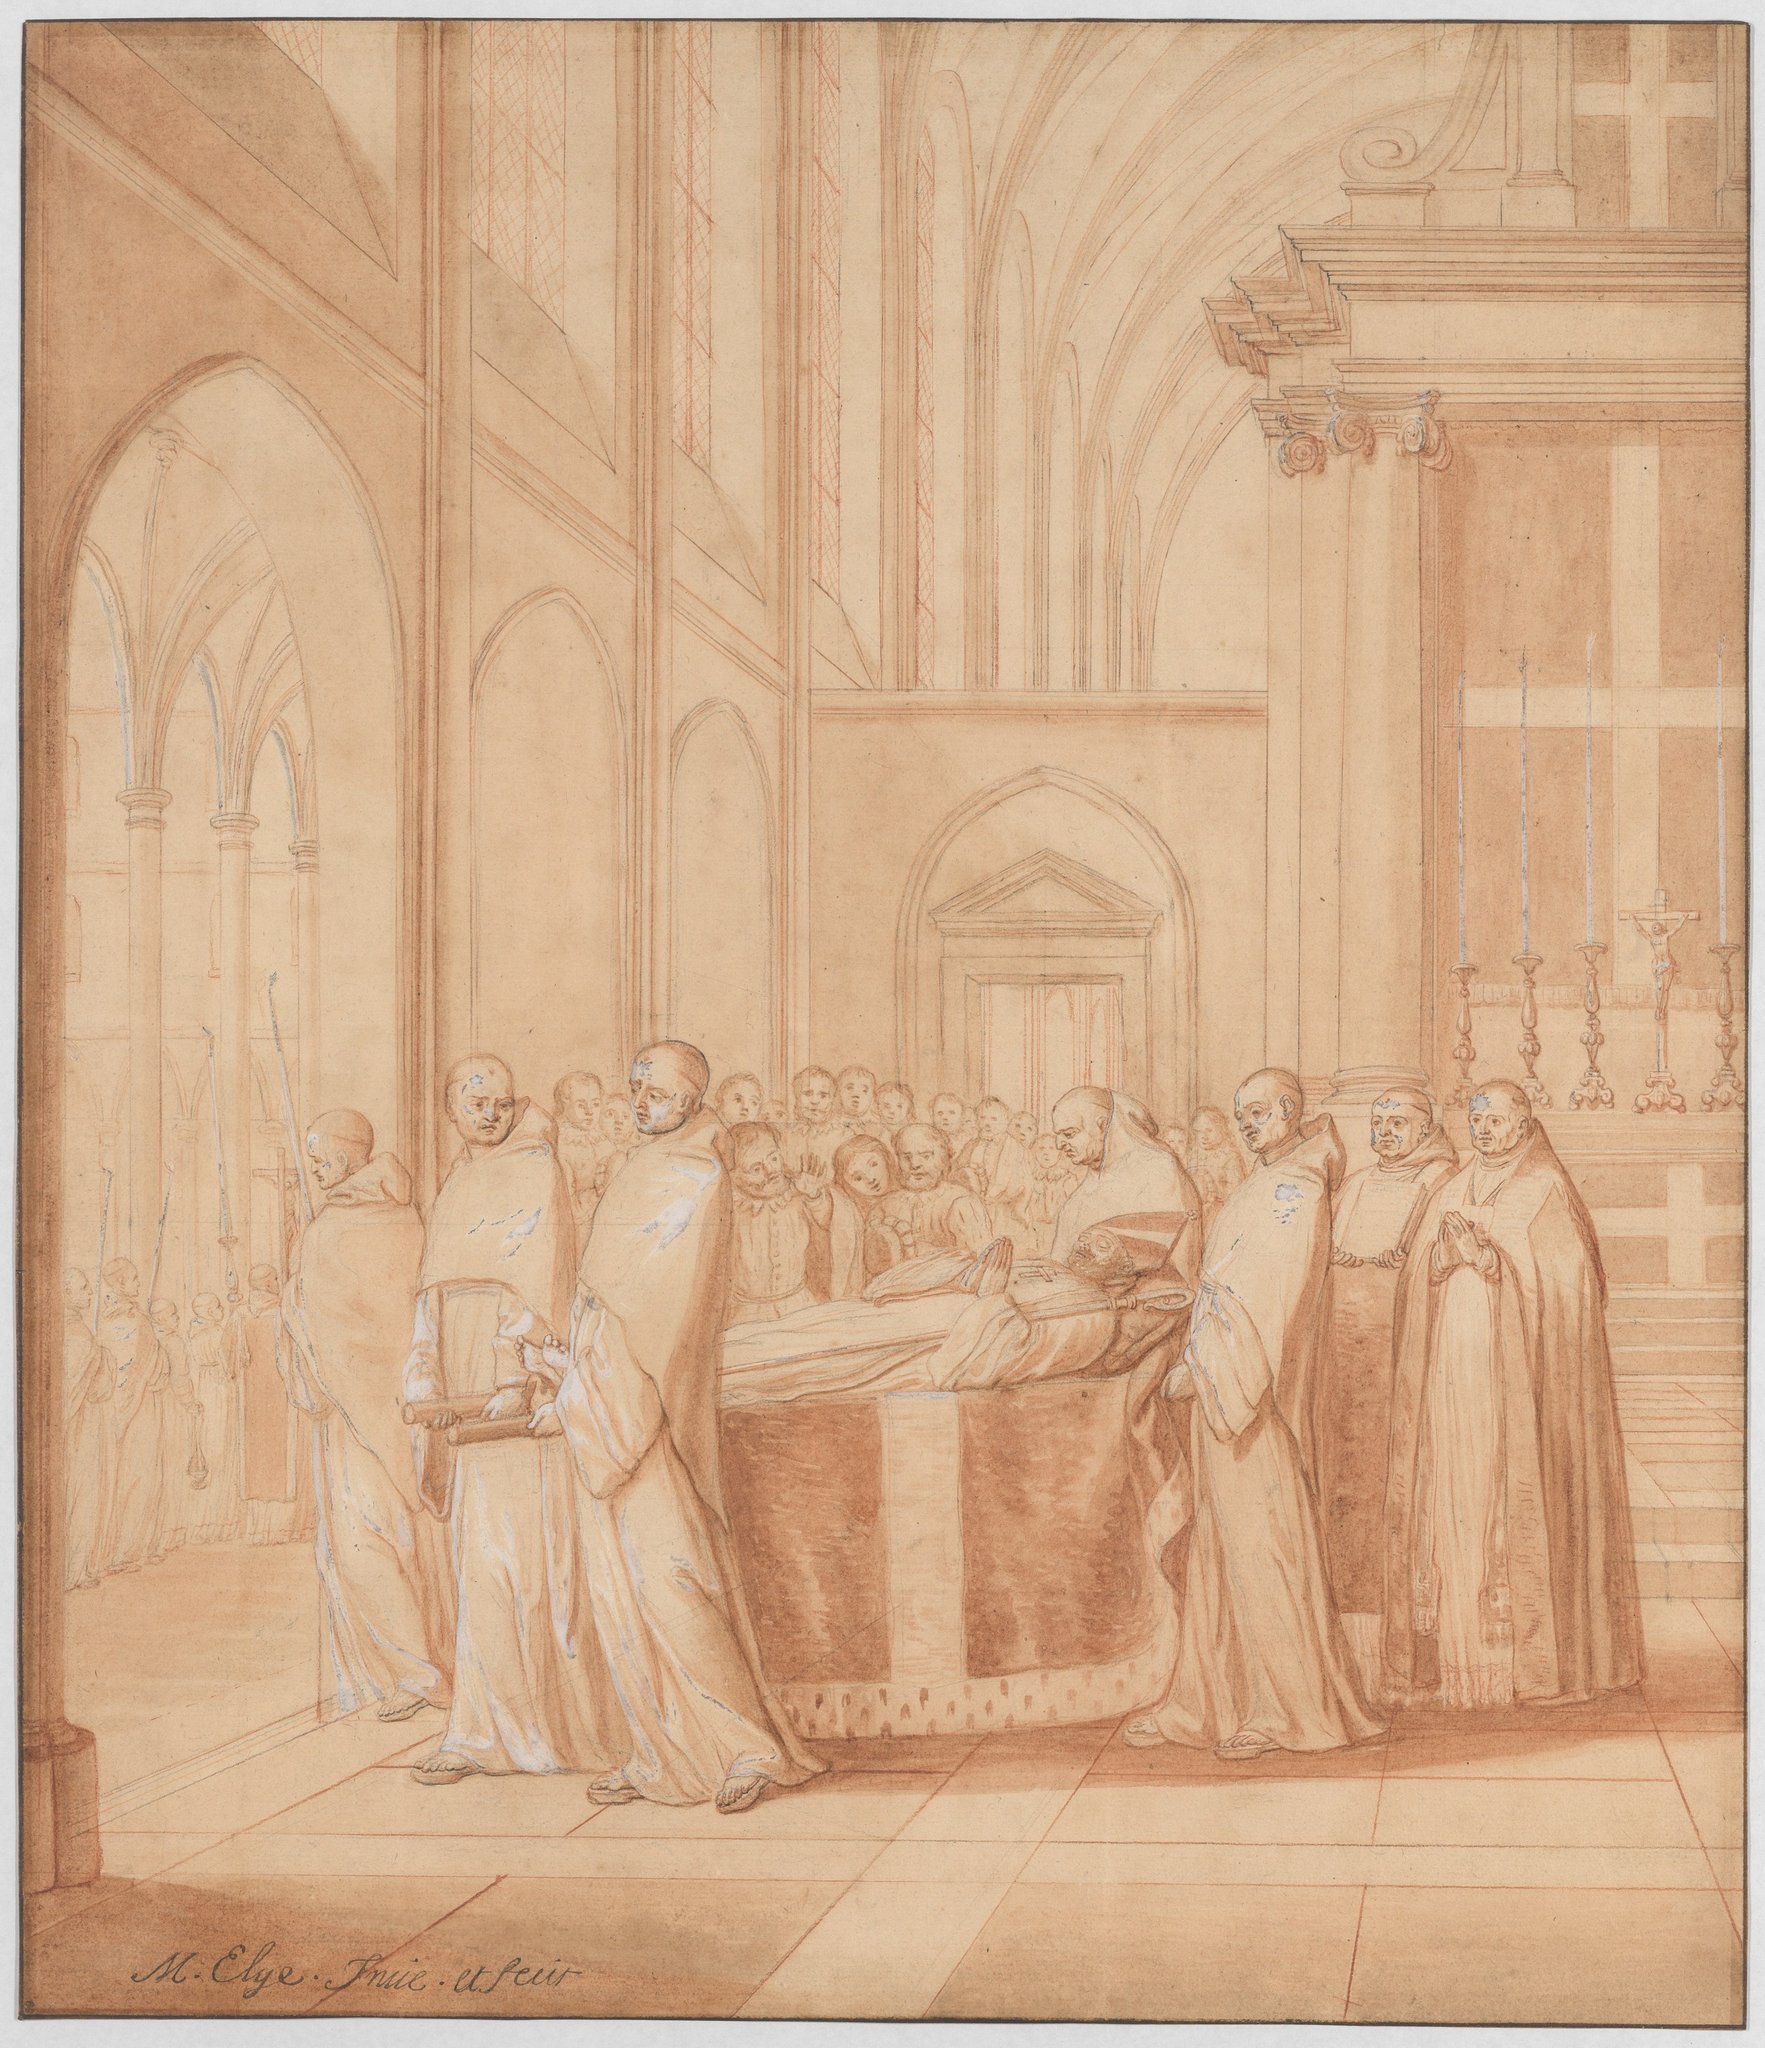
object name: drawing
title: Feuillant monks carry the bier with the body of Jean de la Barrière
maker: matthieu elias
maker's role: artist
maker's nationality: french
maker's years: 1658-1741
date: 1706-1707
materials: chalk, graphite, ink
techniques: brush, heightening, pen, wash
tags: men,death